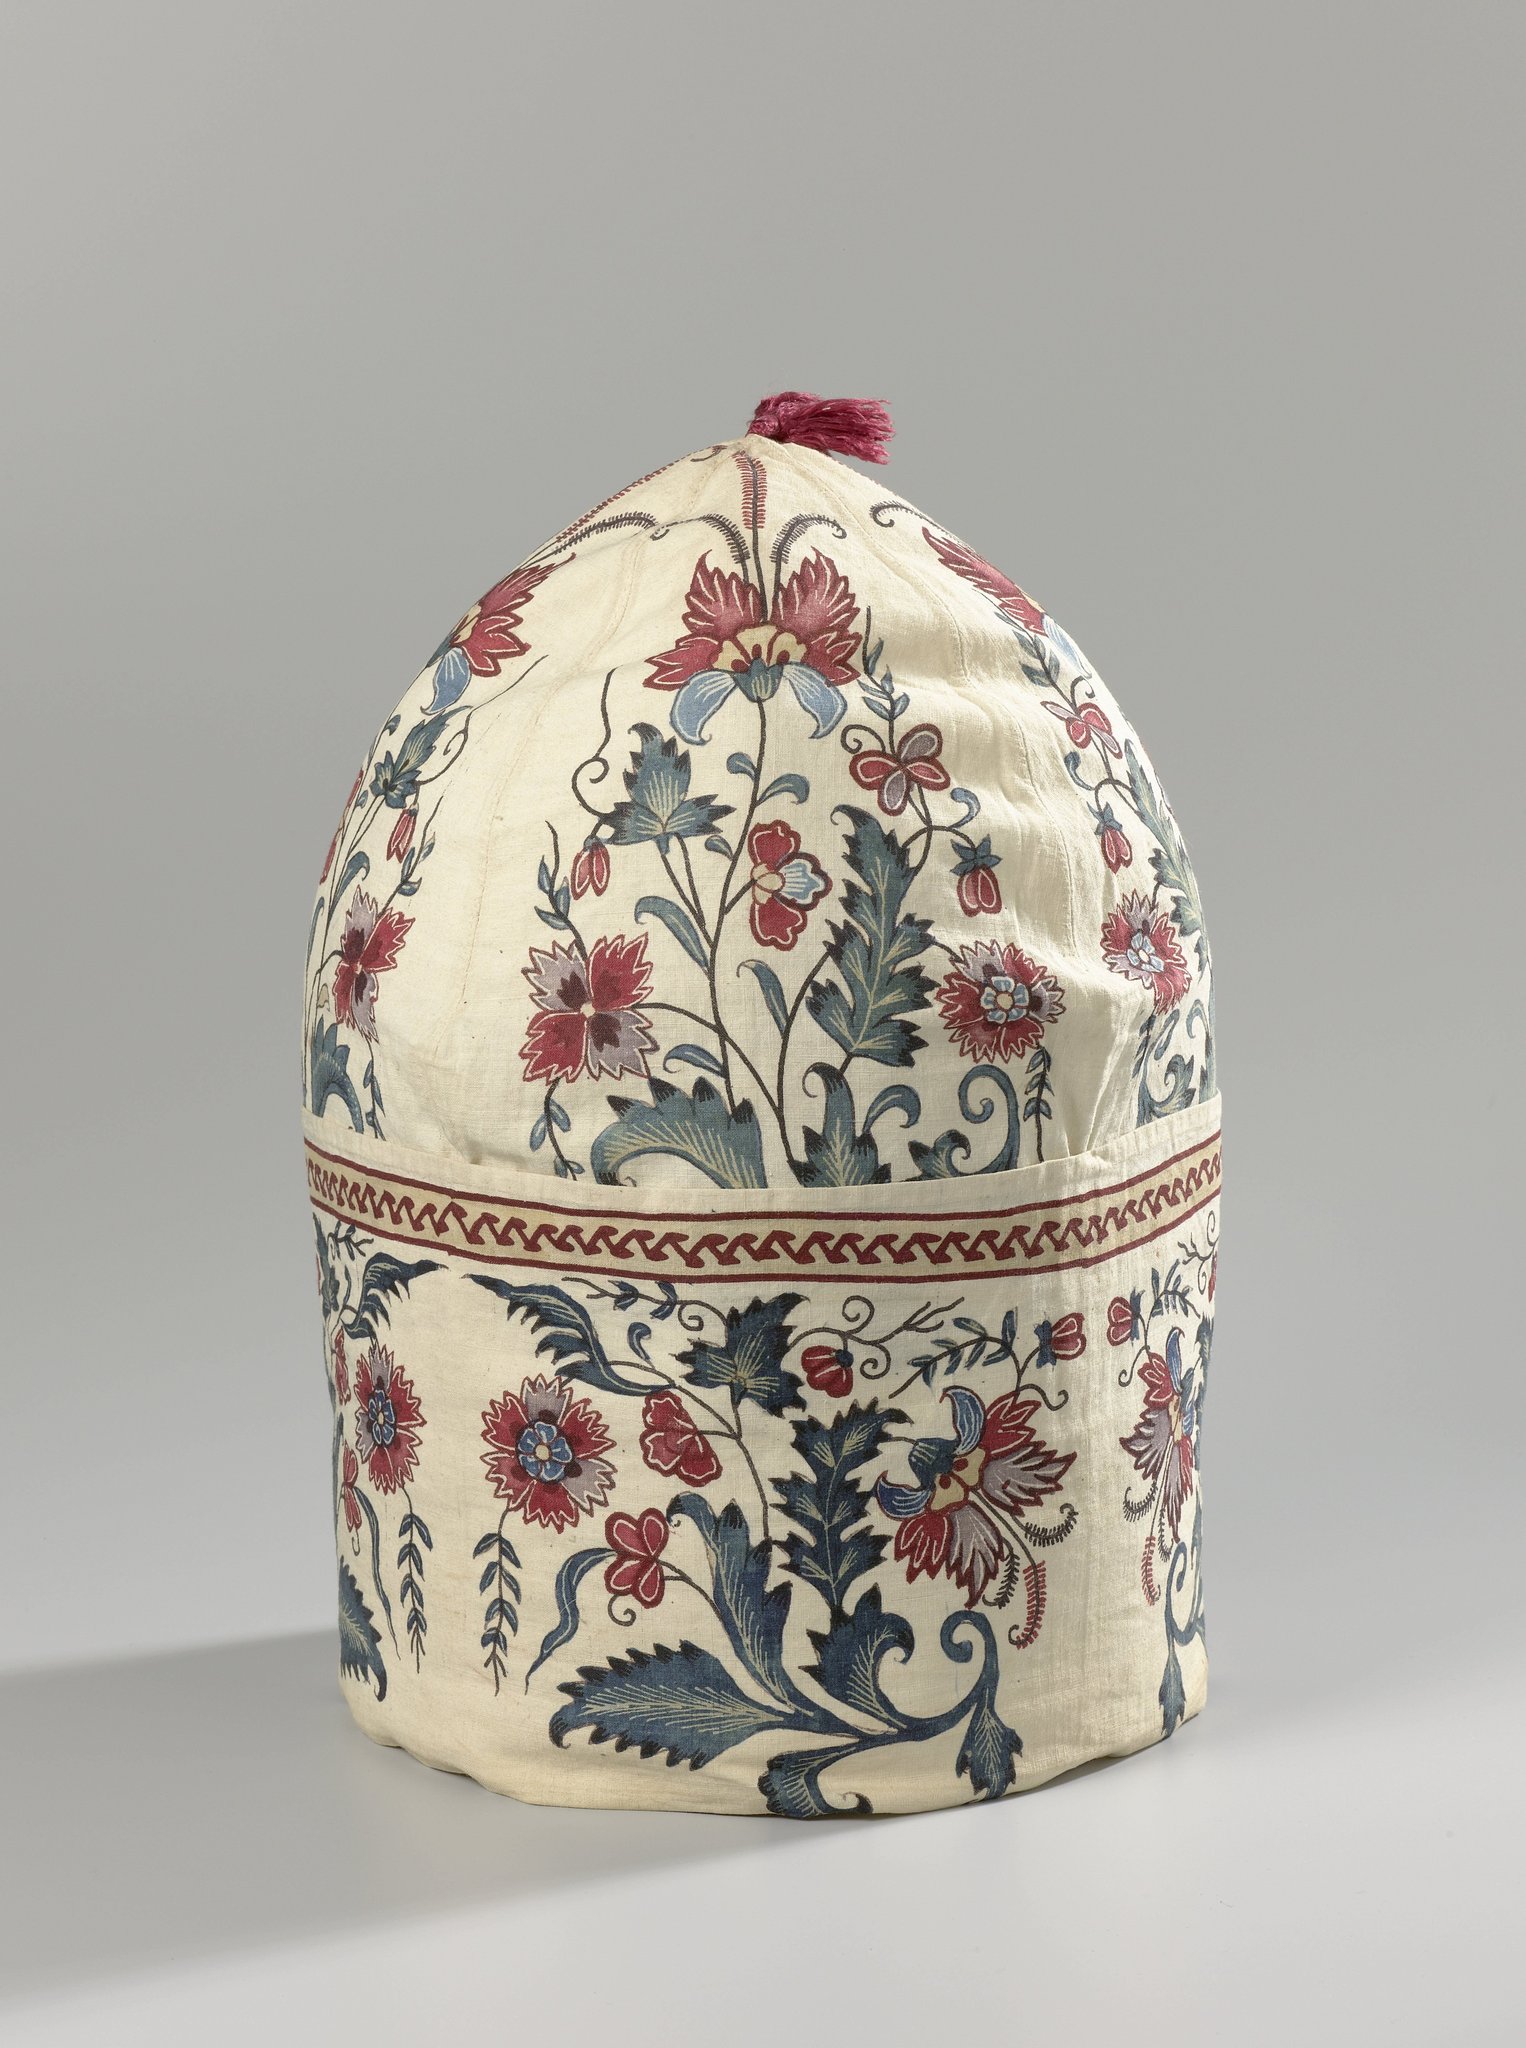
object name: menswear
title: ‘Night’ Cap made of chintz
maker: Anonymous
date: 1750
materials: cotton, silk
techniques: painting, painted, weave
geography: northwest india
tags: jonkheer jan six, painter, gijs bosch reitz, foliage, tendrils, branches ~ ornament, flowers ~ ornament, amsterdam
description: To our knowledge this is the only extant example of a chintz cap. In the Netherlands such caps were worn by gentlemen indoors. Since the model was unknown in India, the pattern – along with instructions for painting the design partly on the front and partly on the back of the piece of cotton – had to be sent from the Netherlands to India.